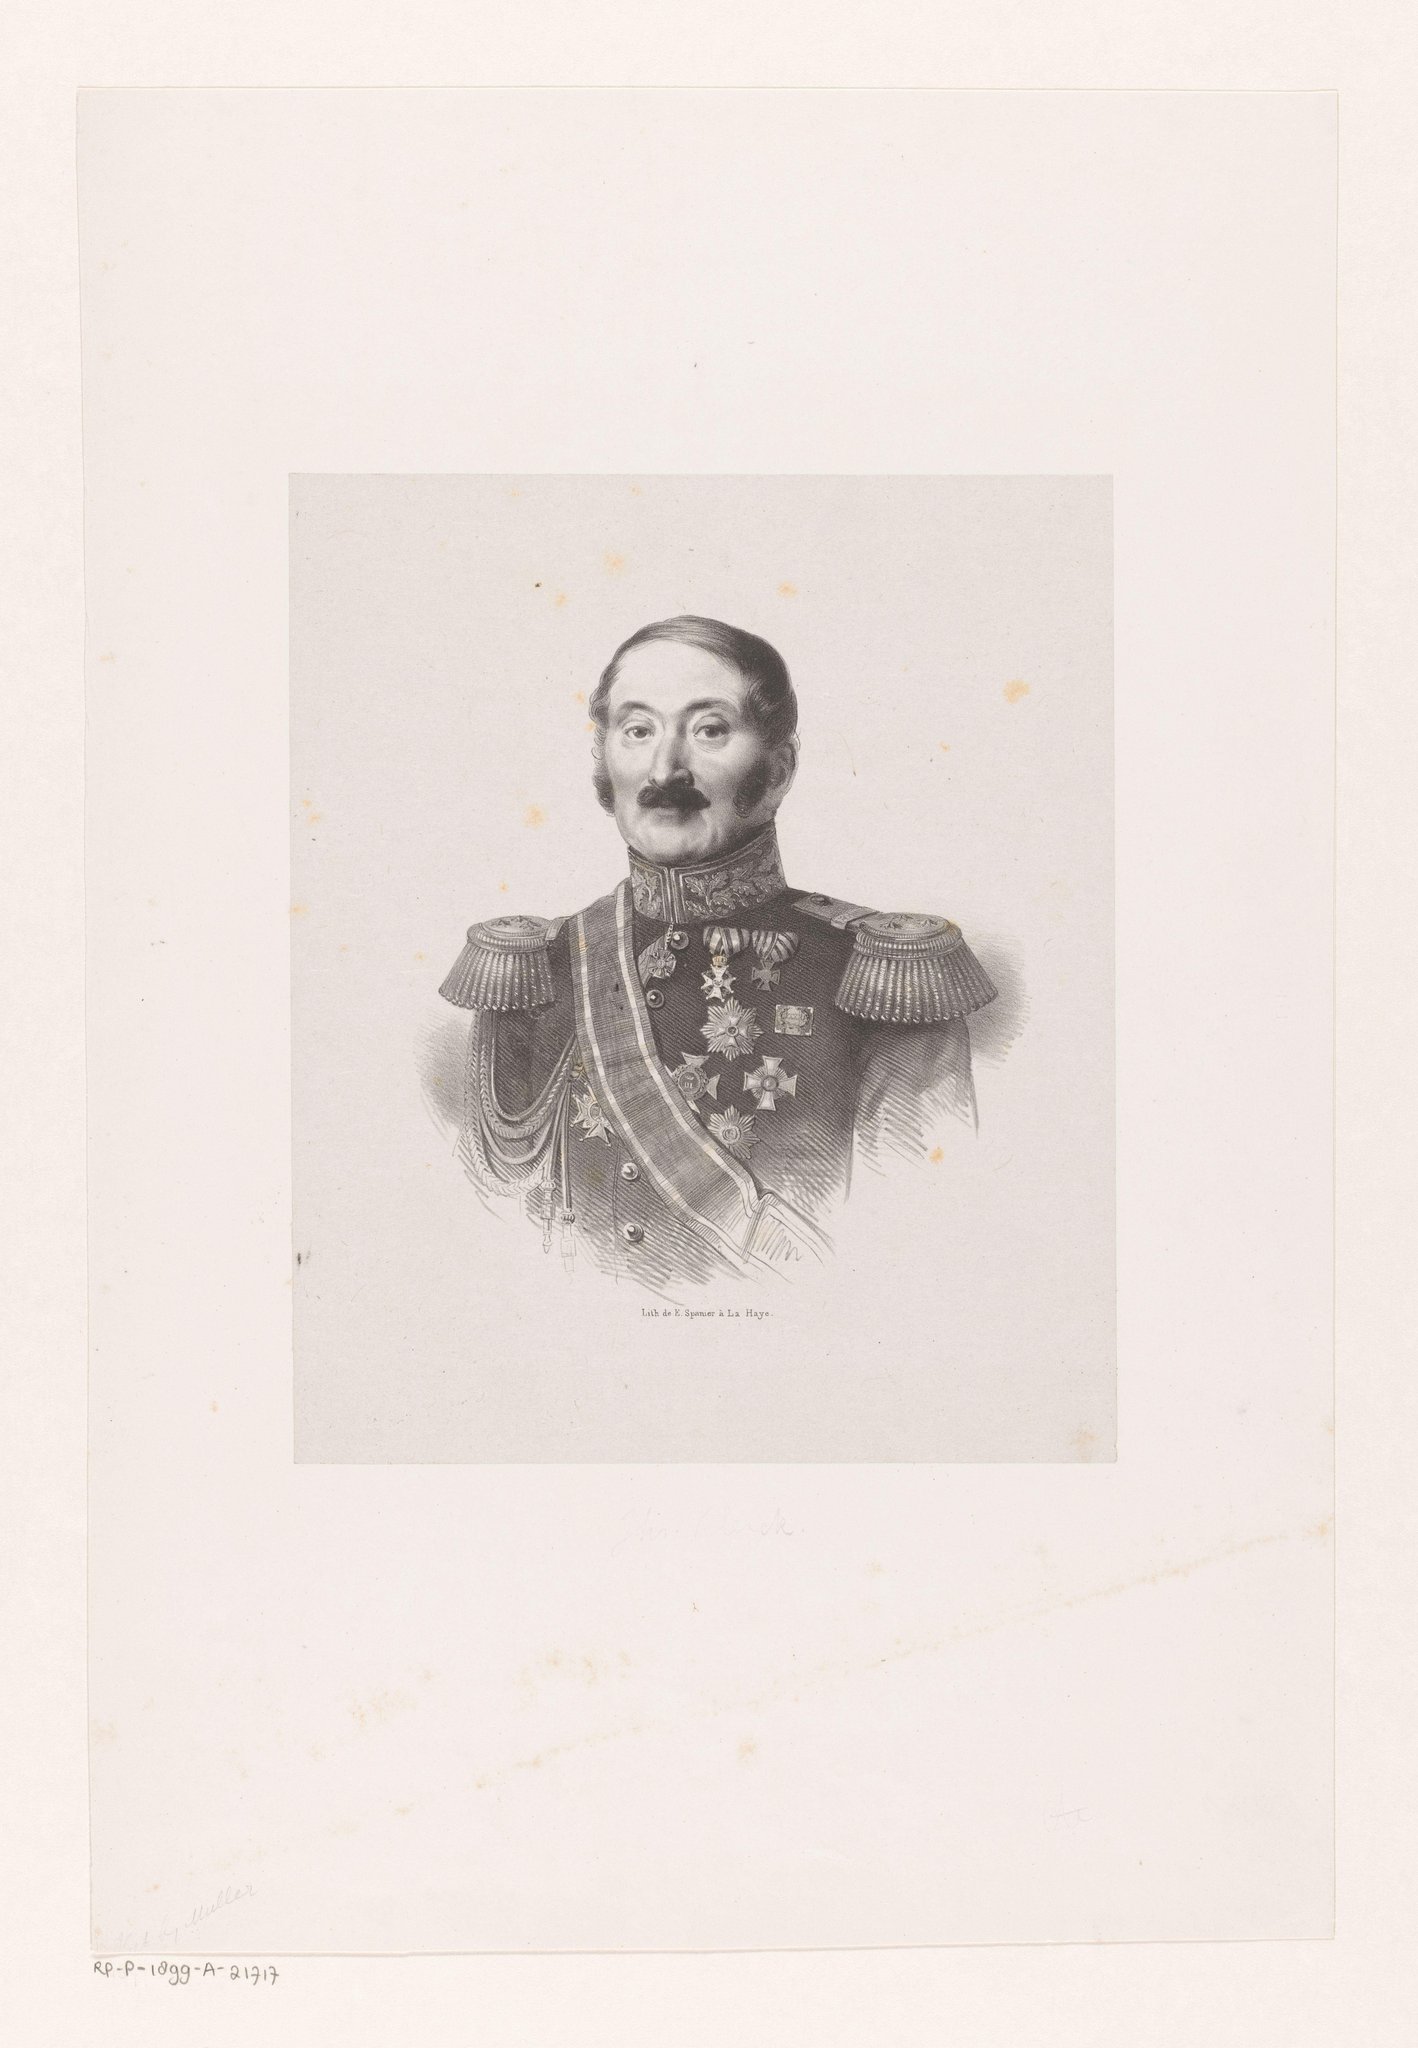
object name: print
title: Portret van Rijnholt Antony Klerck in militair kostuum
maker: johan hendrik hoffmeister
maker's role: print maker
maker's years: 1823-1904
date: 1851-1883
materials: paper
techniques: lithograph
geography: the hague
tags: knighthood order, historical persons (+ (full) bust portrait)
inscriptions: collector's mark: Lugt 2228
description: Aan deze staat ontbreekt de signatuur en de naam van de prentmaker. Daarbij verschilt de voorstelling, bijvoorbeeld in het lint en de ordetekenen.